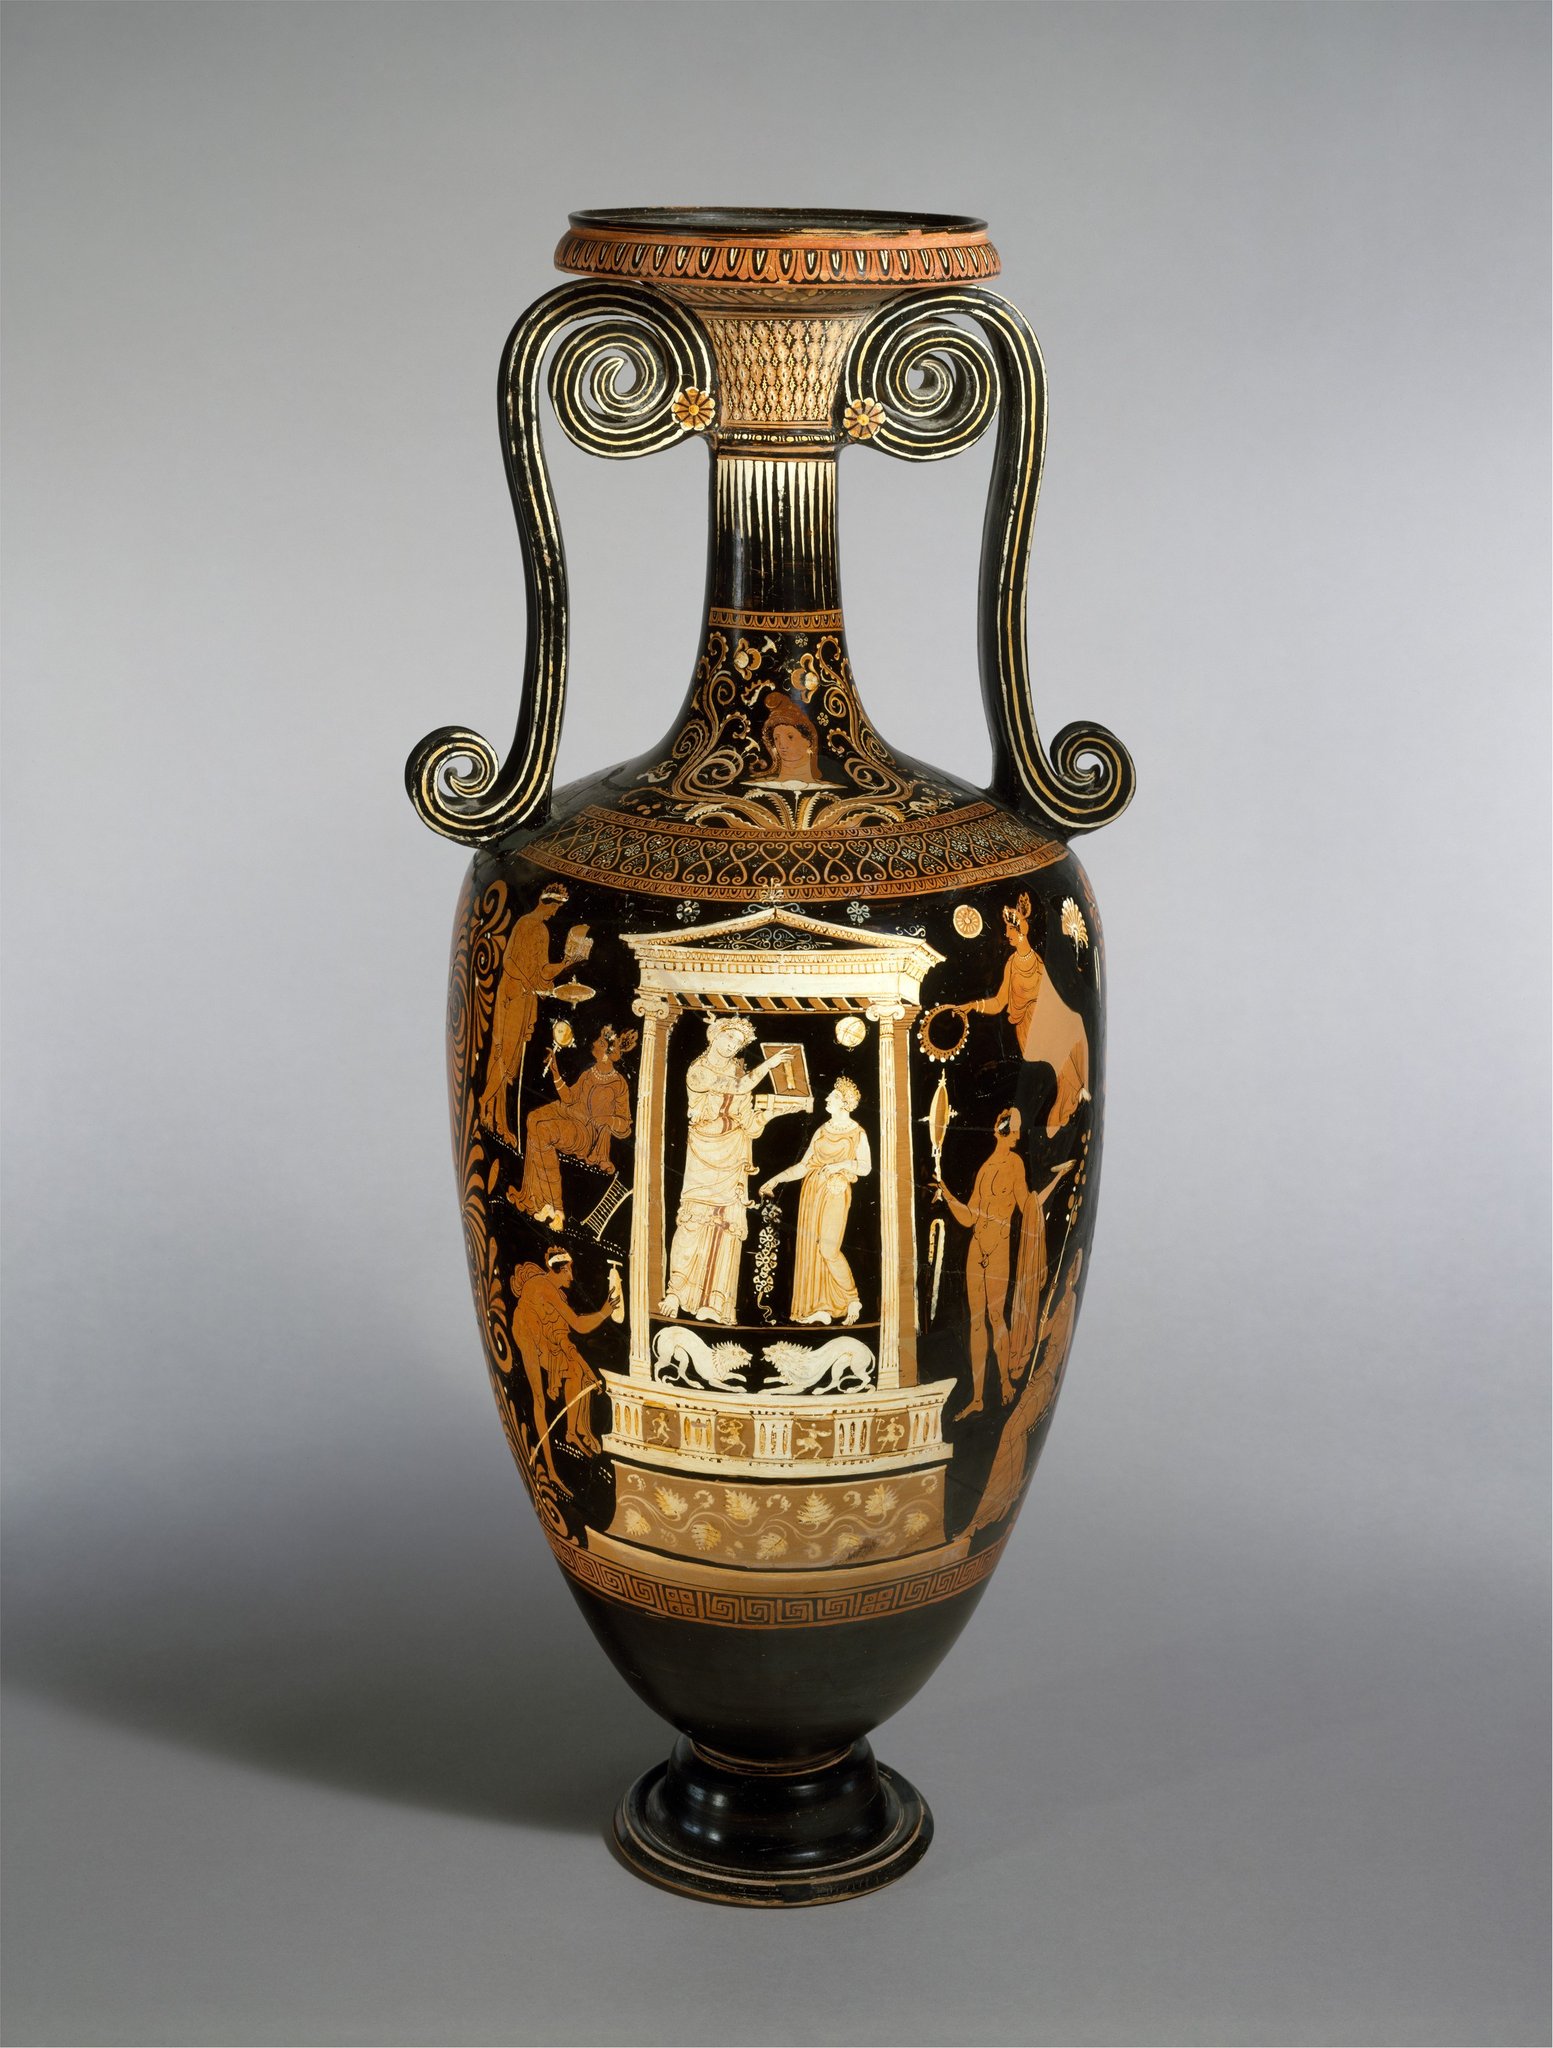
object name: loutrophoros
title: Terracotta loutrophoros (ceremonial vase for water)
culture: greek, south italian, apulian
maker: metope painter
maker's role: artist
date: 350-326 BCE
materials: terracotta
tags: male nudes,women,lions